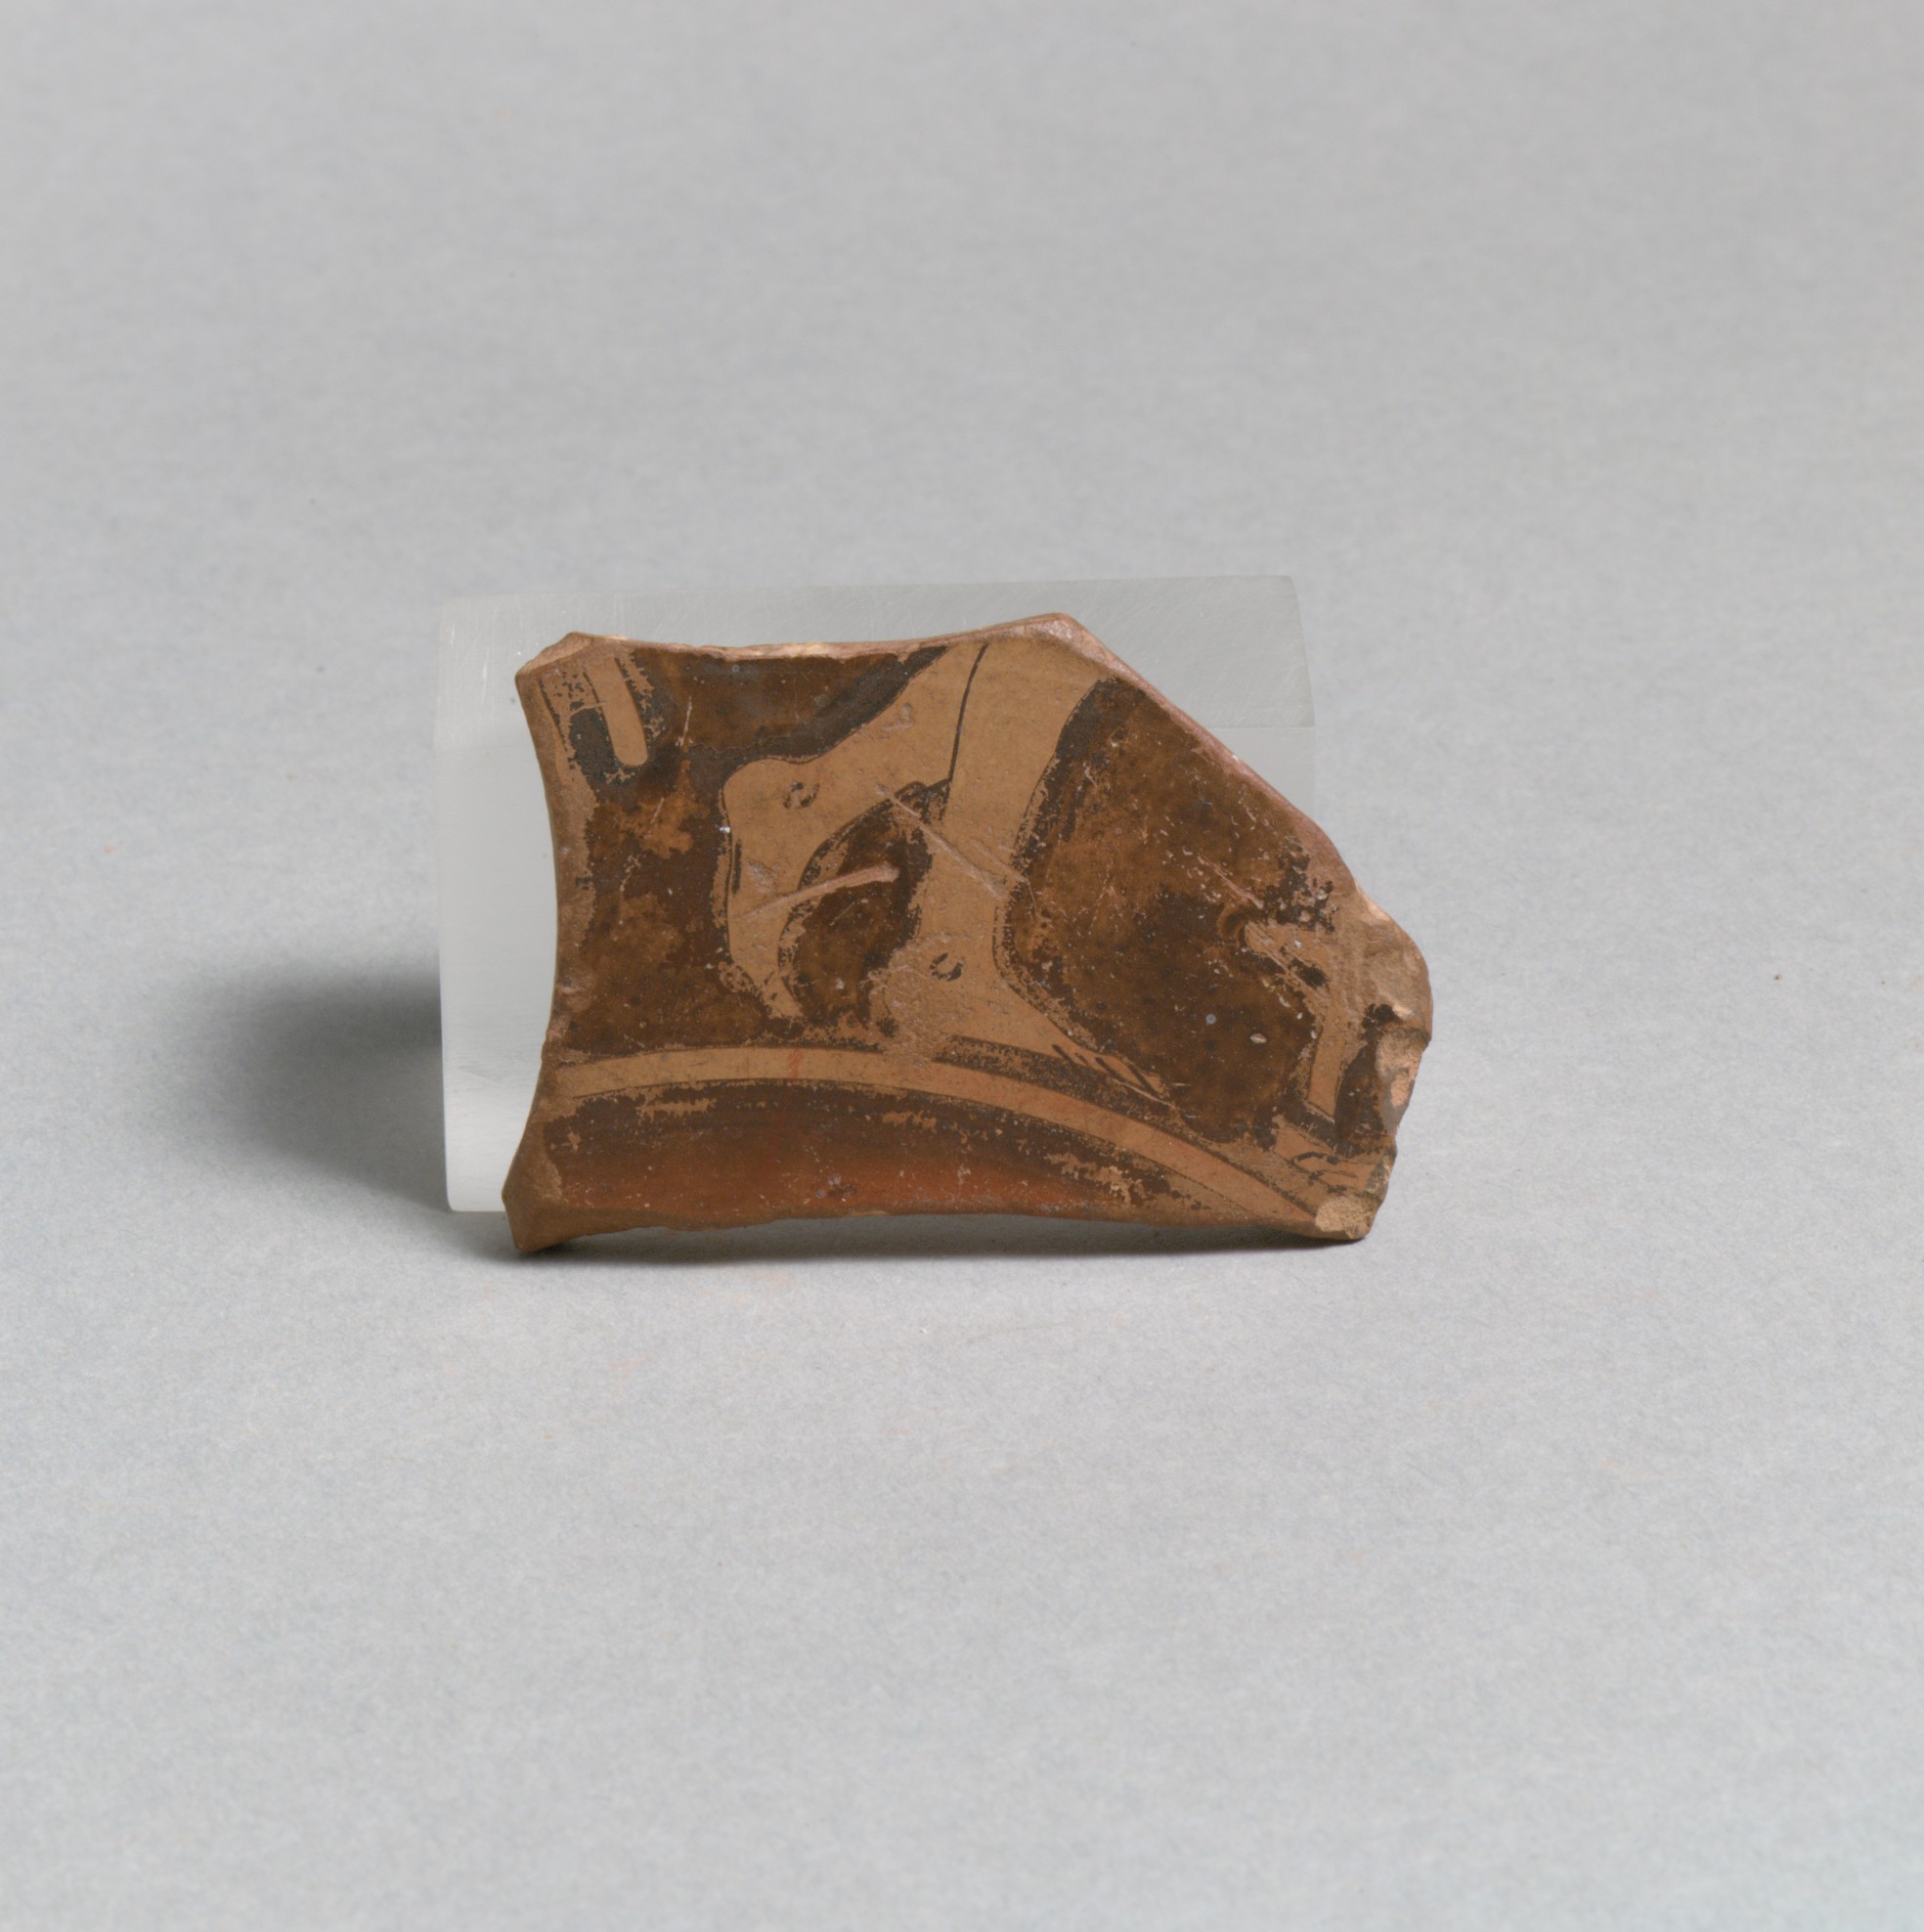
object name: kylix fragment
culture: greek, attic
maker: splanchnopt painter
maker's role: artist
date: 470 BCE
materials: terracotta